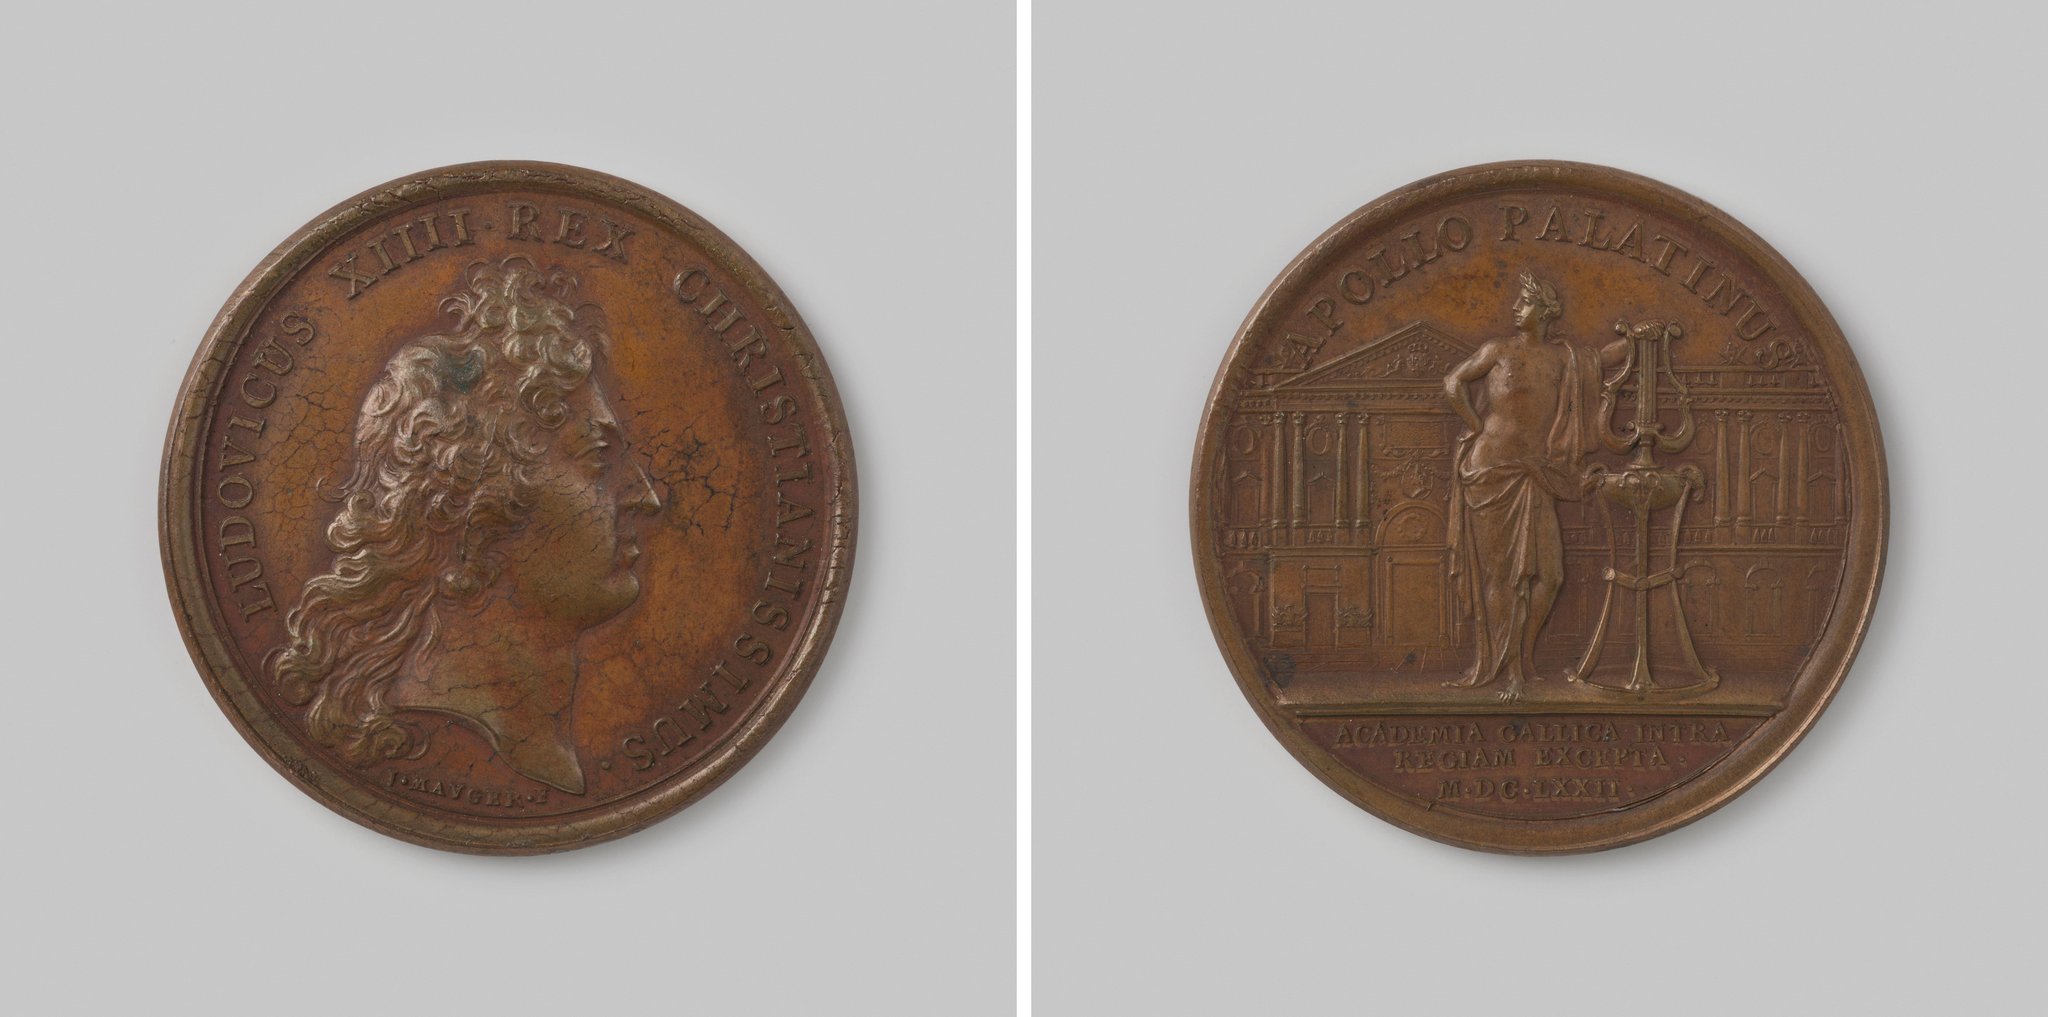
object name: history medal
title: Installatie van de Academie francaise 1672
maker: jean mauger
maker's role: medailleur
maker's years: 1648-1722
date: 1672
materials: copper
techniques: striking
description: Koperen penning, op de voorzijde het portret van Koning Lodewijk XIV naar rechts met omschrift, op de keerzijde Apollo staand met zijn lier op een driepoot met op de achtergrond het Académiegebouw, met omschrift en afsnedetekst.